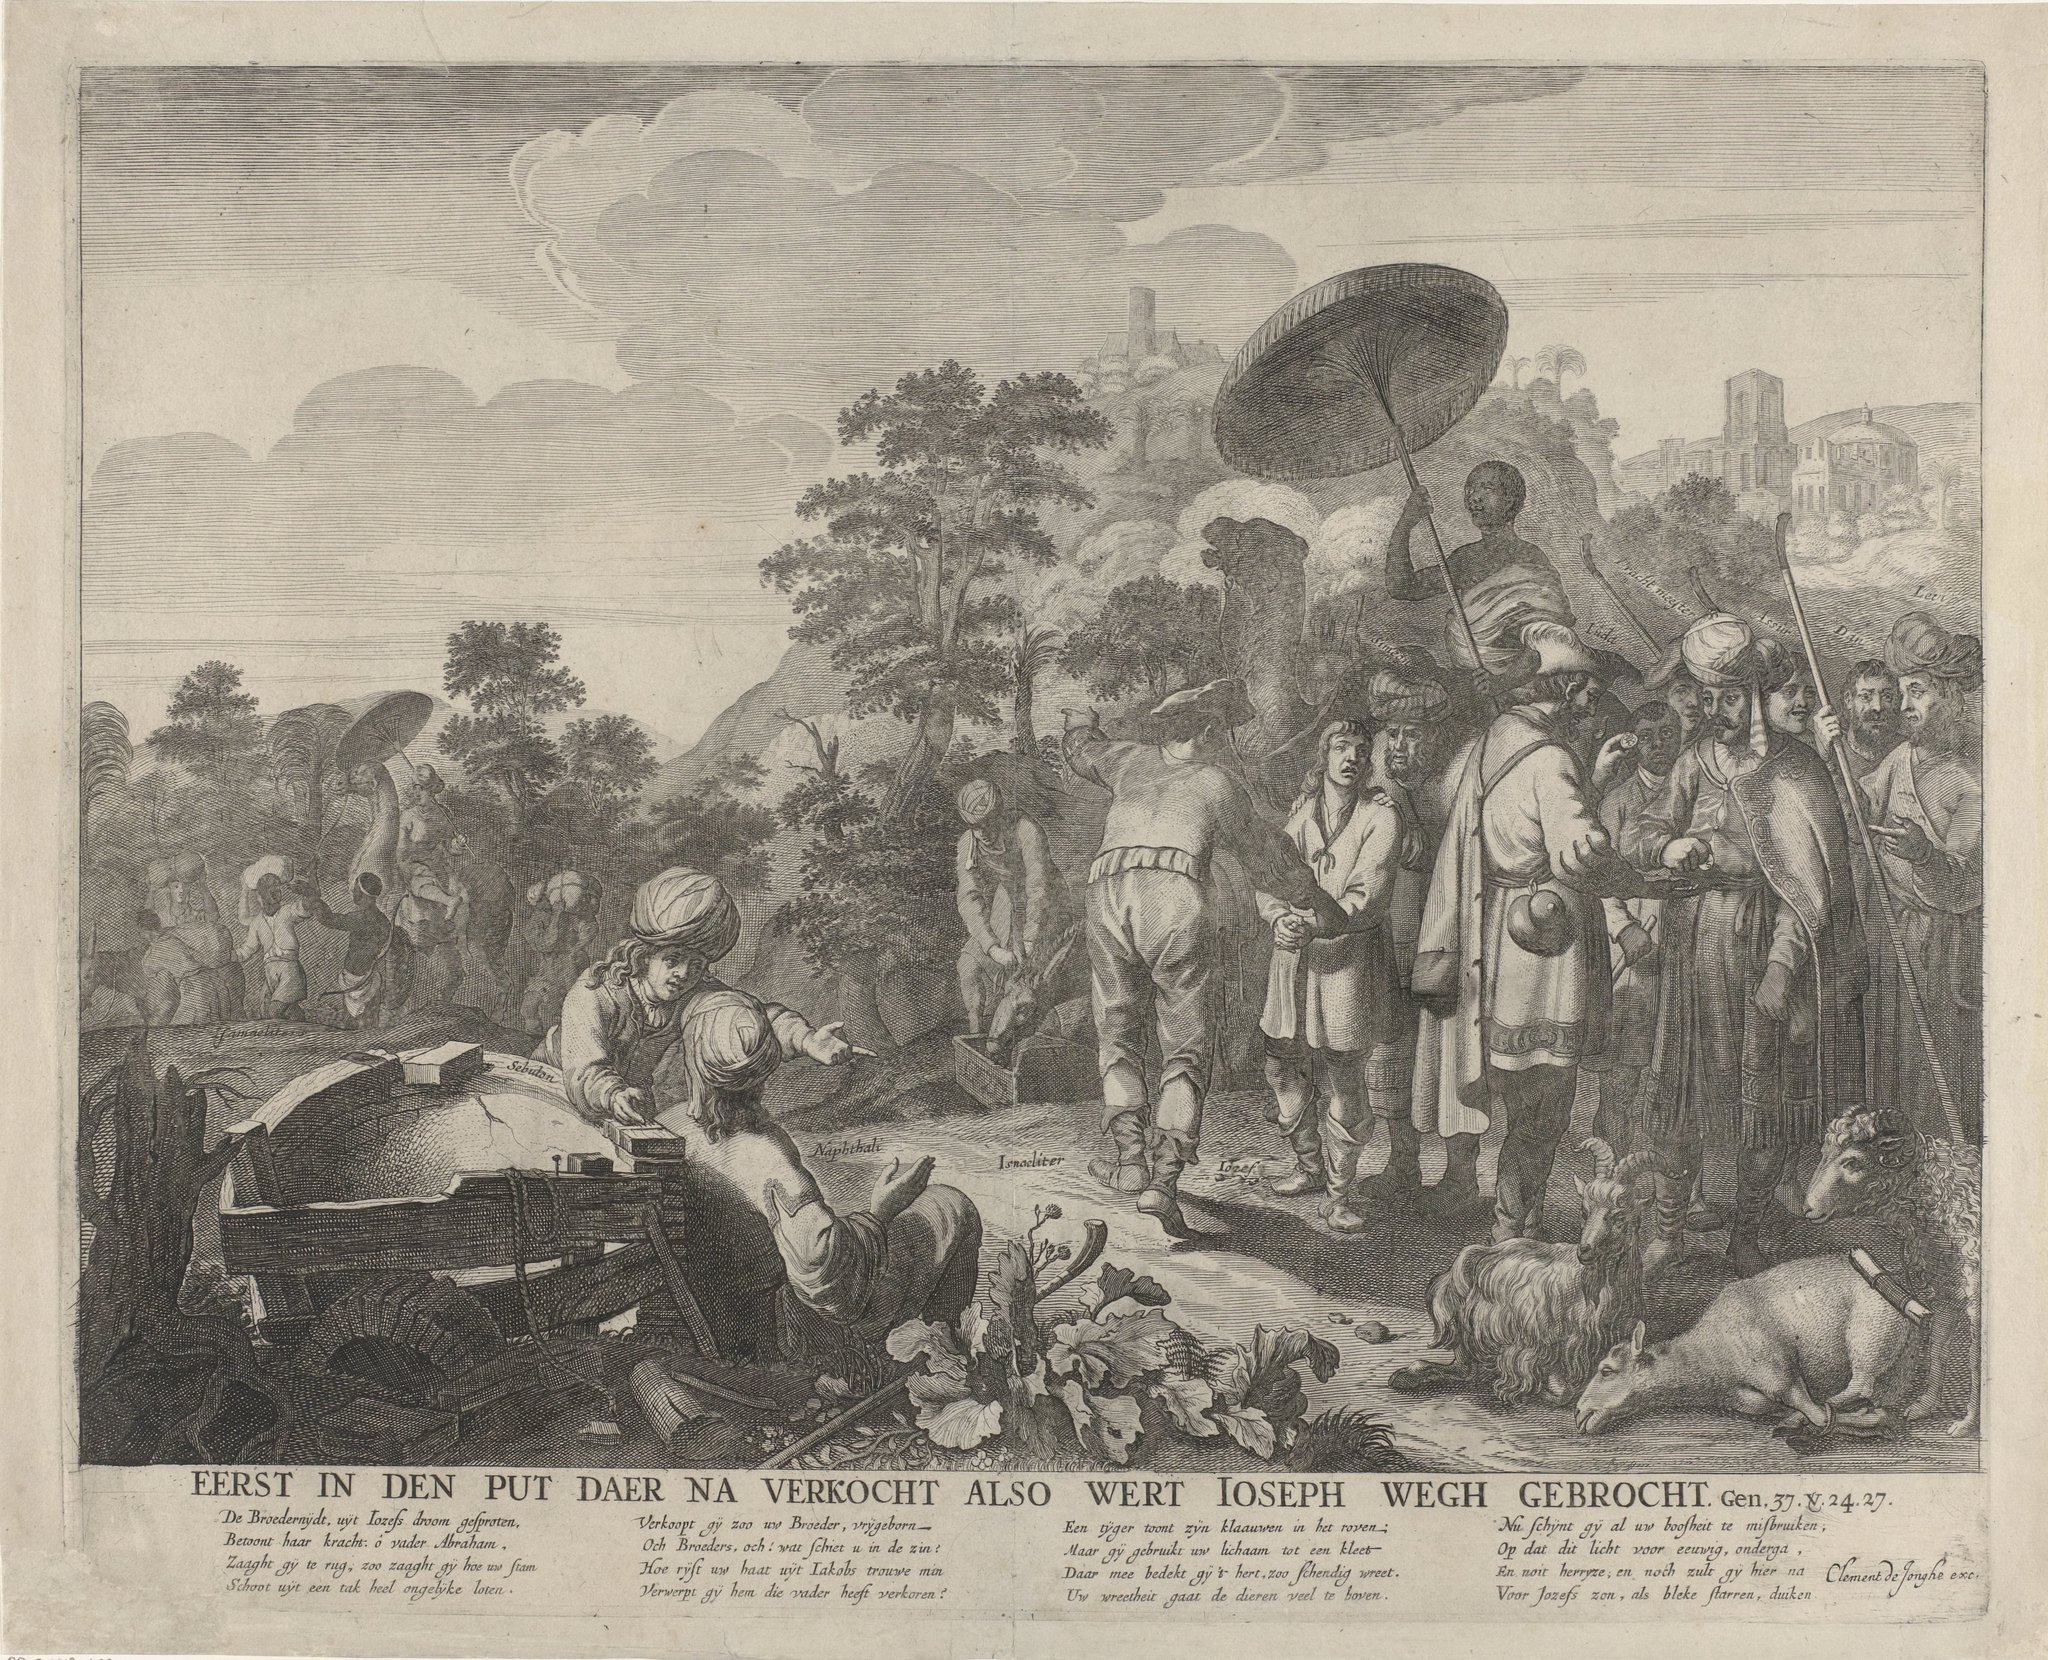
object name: print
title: Jozef door zijn broers verkocht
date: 1639-1677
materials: paper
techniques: engraving, etching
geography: amsterdam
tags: joseph is sold for twenty pieces of silver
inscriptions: caption: ‘EERST IN DEN PUT DAER NA VERKOCHT ALSO WERT JOSEPH WEGH GEBROCHT. Gen. 37.v. 24.27. Daaronder 4 x 4 regels nederlands onderschrift: De Broedernijdt, uyt Iozefs droom gesproten...Voor Jozefs zon, als de bleke starren, duiken.’, address: ‘Clement de Jonghe exc.’, collector's mark: Lugt 2228, collector's mark: Lugt 2760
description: Royaalbijbel-prent uitgegeven door Clement de Jonghe. Verschillende Amsterdamse uitgevers gaven vanaf de jaren ’30 van de zeventiende eeuw grote Bijbelse prenten op zogenaamd royaal-formaat papier (ca. 480 x 580 mm) uit. De uitgave van royaalbijbelprenten door de firma Visscher van Claes Jansz. Visscher (II), Nicolaes Visscher (I) en (II) is het meest bekend, maar ook uitgevers als Clement de Jonghe en Cornelis Danckerts brachten deze populaire prenten op de markt.